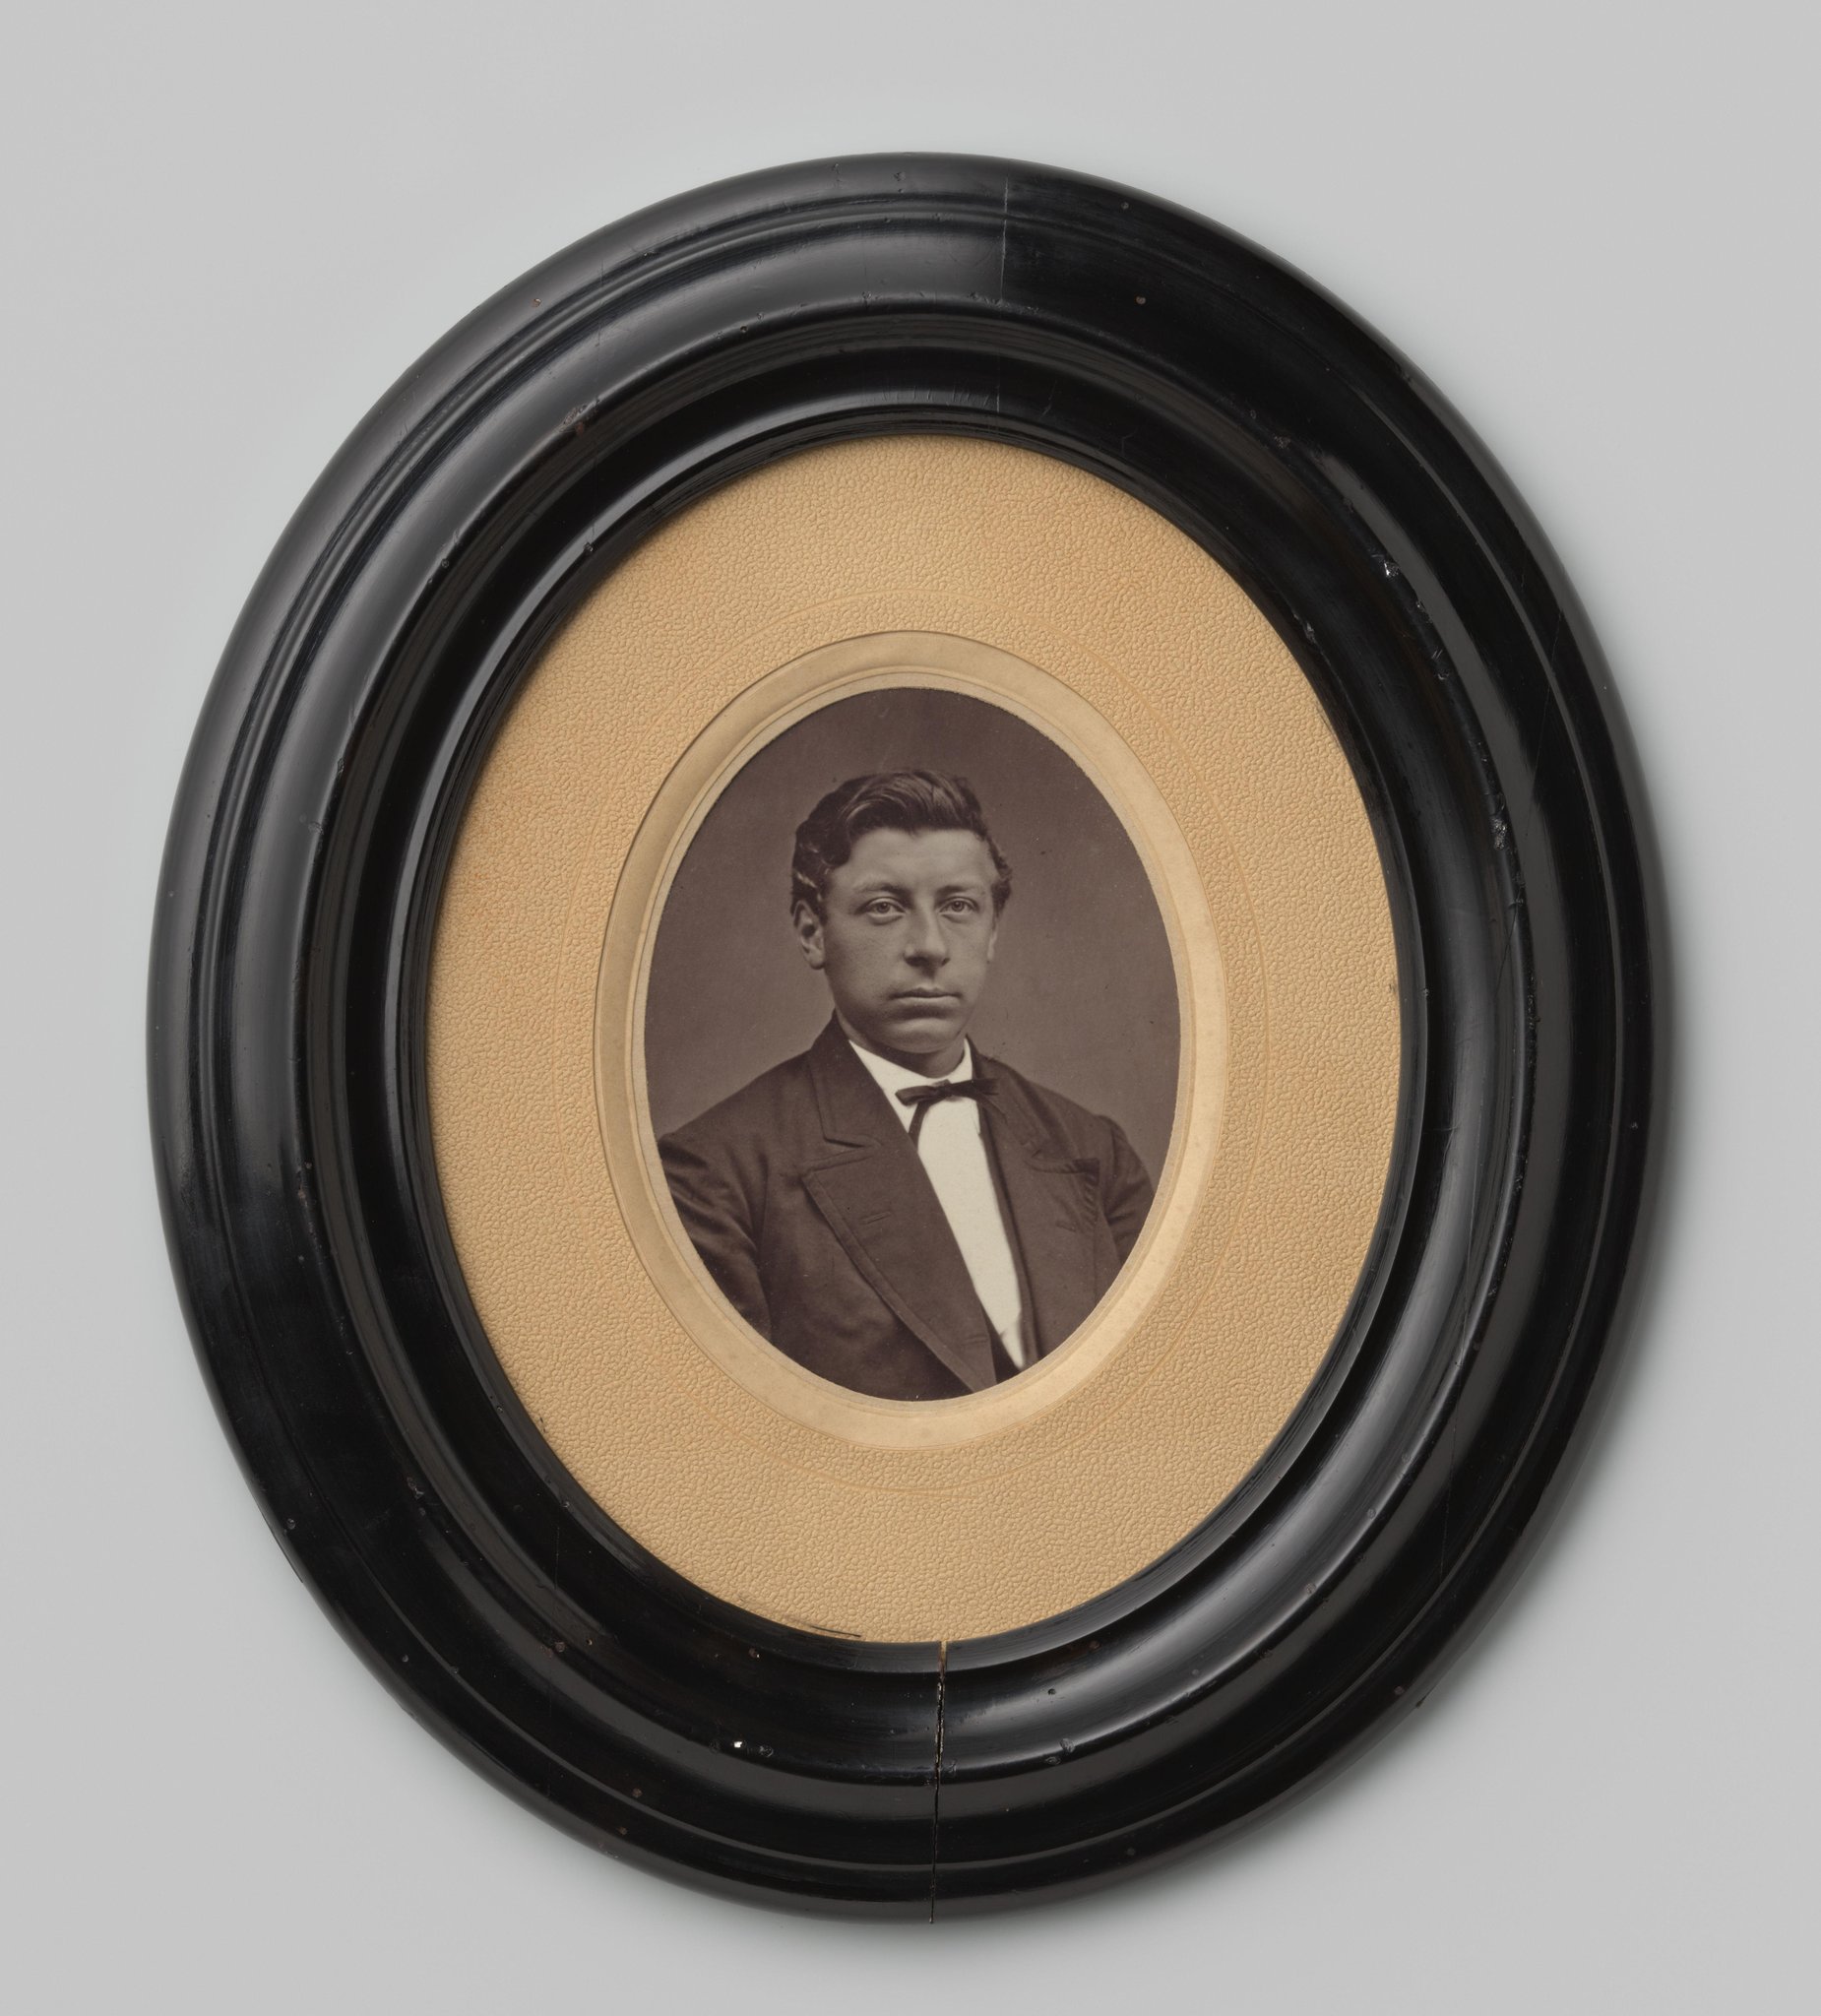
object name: photograph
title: Portret van een onbekende man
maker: louis robert werner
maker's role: fotograaf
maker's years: 1834-1896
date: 1866-1896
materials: cardboard, glass, metal, paper, wood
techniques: carbon print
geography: amsterdam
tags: adult man, anonymous historical person portrayed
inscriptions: inscription: ‘PHOTOGRAPHIE/ van/ L.R. WERNER/ voorheen/ P. CARSTENSEN./ Nieuwendijk 3de huis van de Dirk/ van Hasfeltsteeg, No. 150./ AMSTERDAM.’